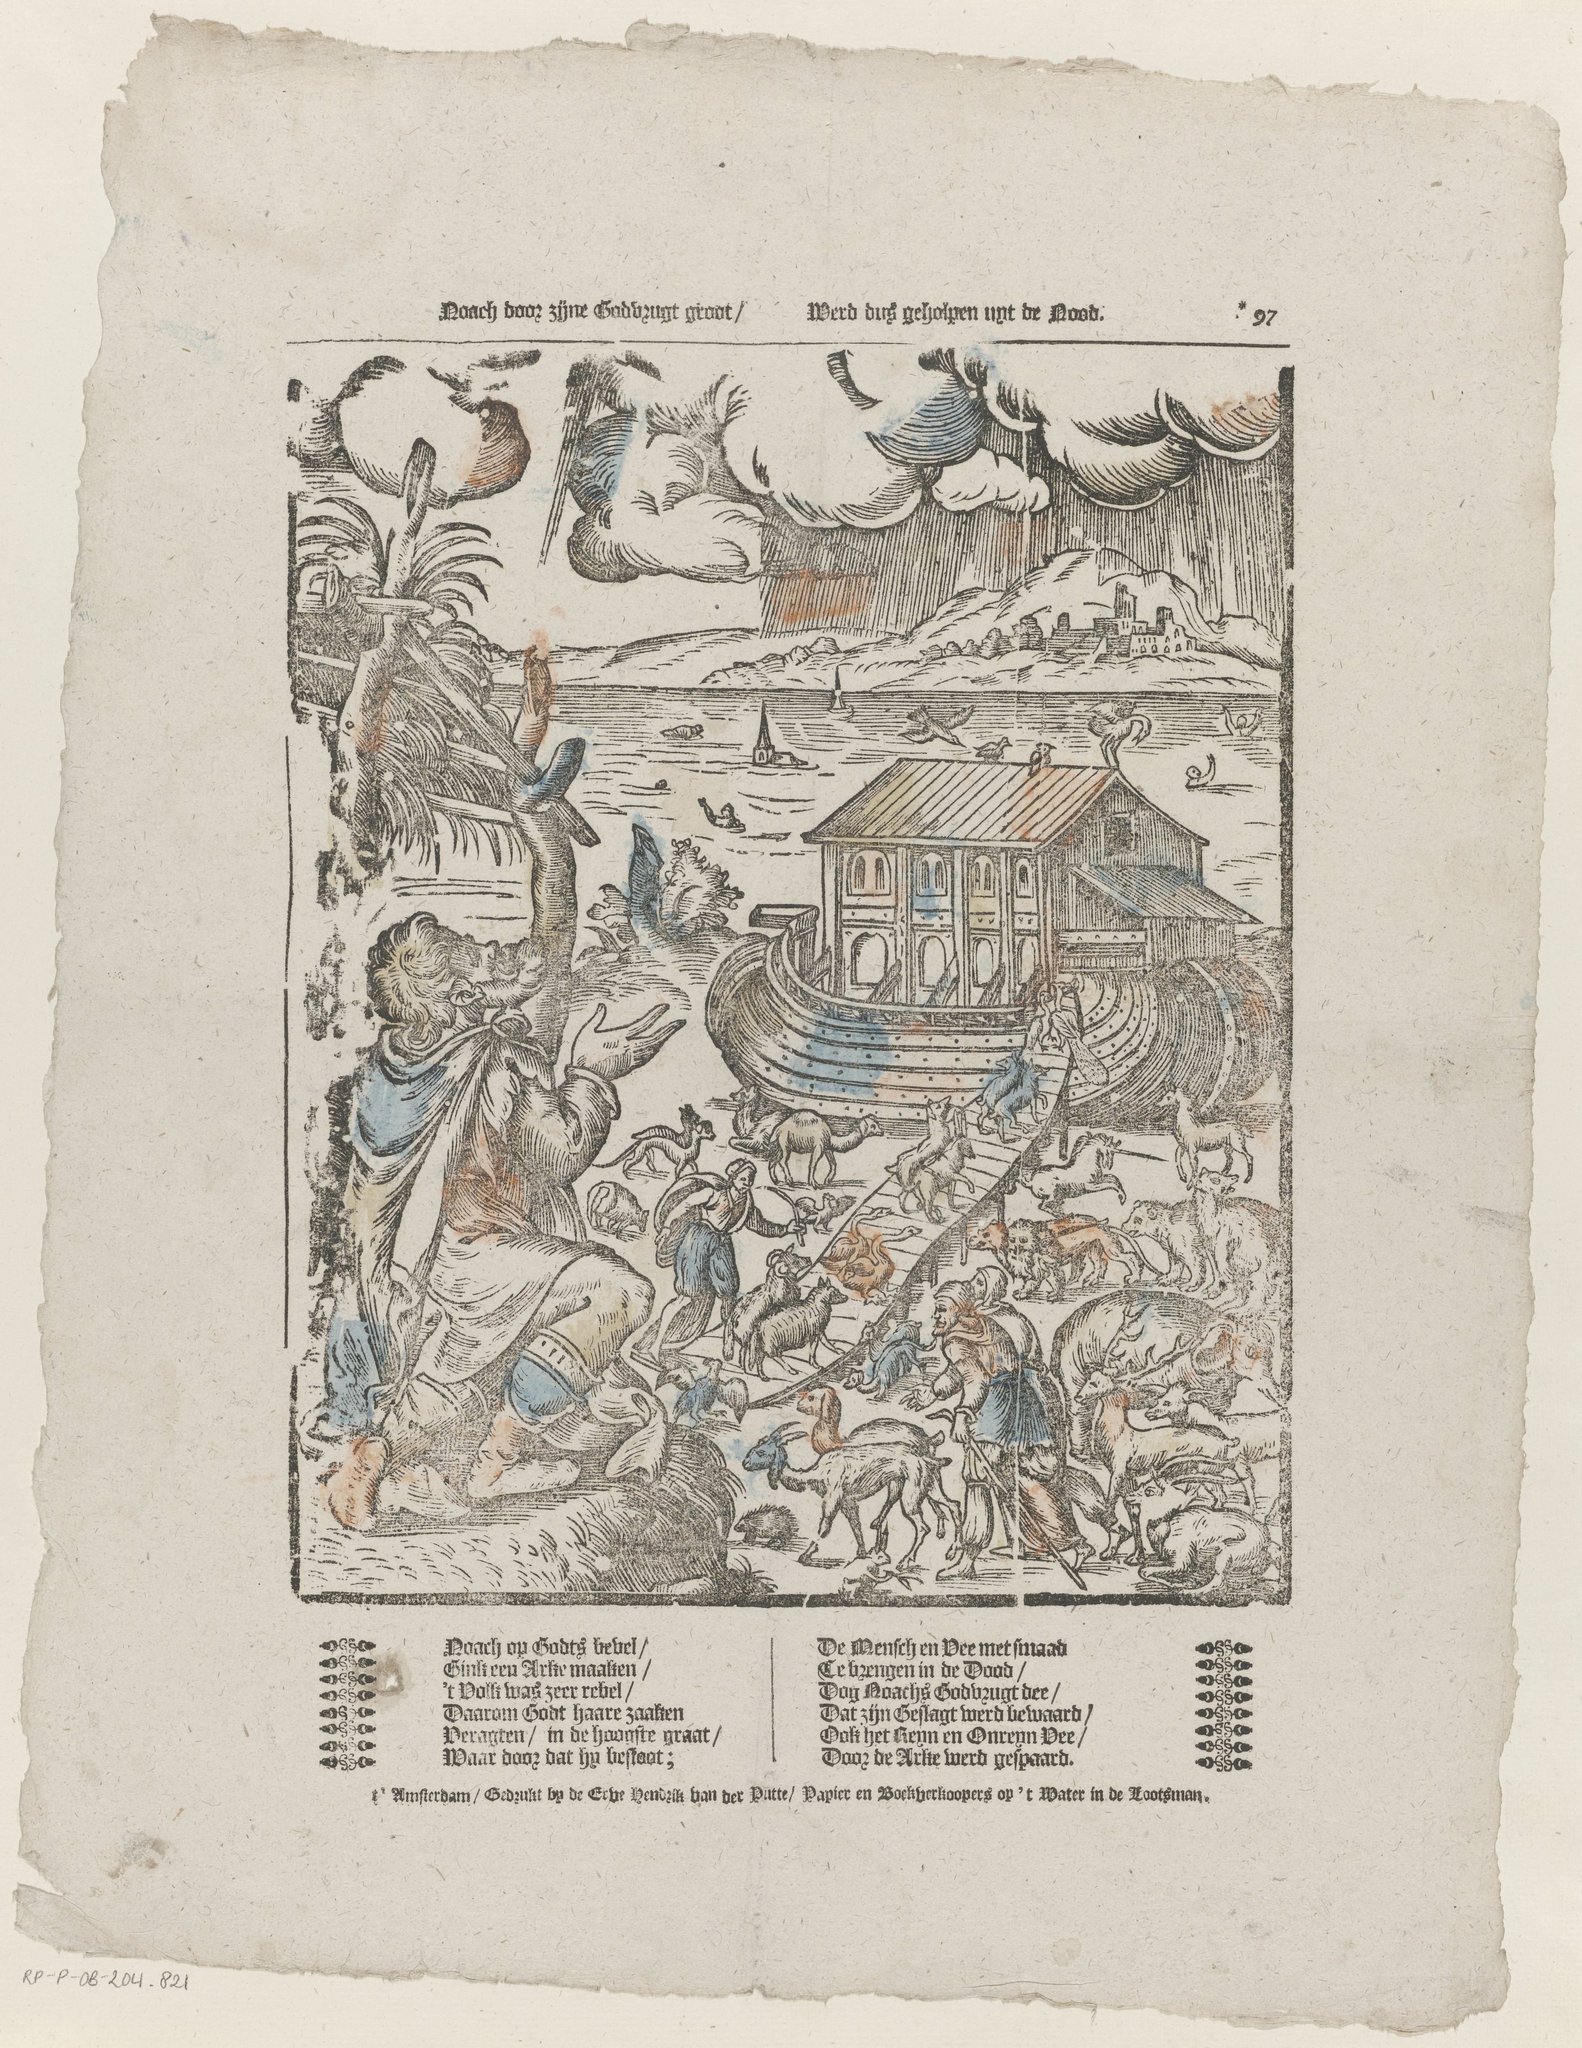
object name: print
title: Noach door zijne Godsvrugt groot / Werd dus geholpen uyt de Nood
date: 1767-1793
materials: paper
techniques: colour, letterpress printing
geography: amsterdam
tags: the ark ~ story of noah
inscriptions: collector's mark: Lugt 2760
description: De ark van Noach. Op de achtergrond stormt het hevig en stijgt het water. Mensen en dieren verdrinken. Op de voorgrond gaan paren van verschillende diersoorten aan boord van Noachs ark. Onder de afbeelding een twaalfregelig vers in twee kolommen. Genummerd rechtsboven: *97.